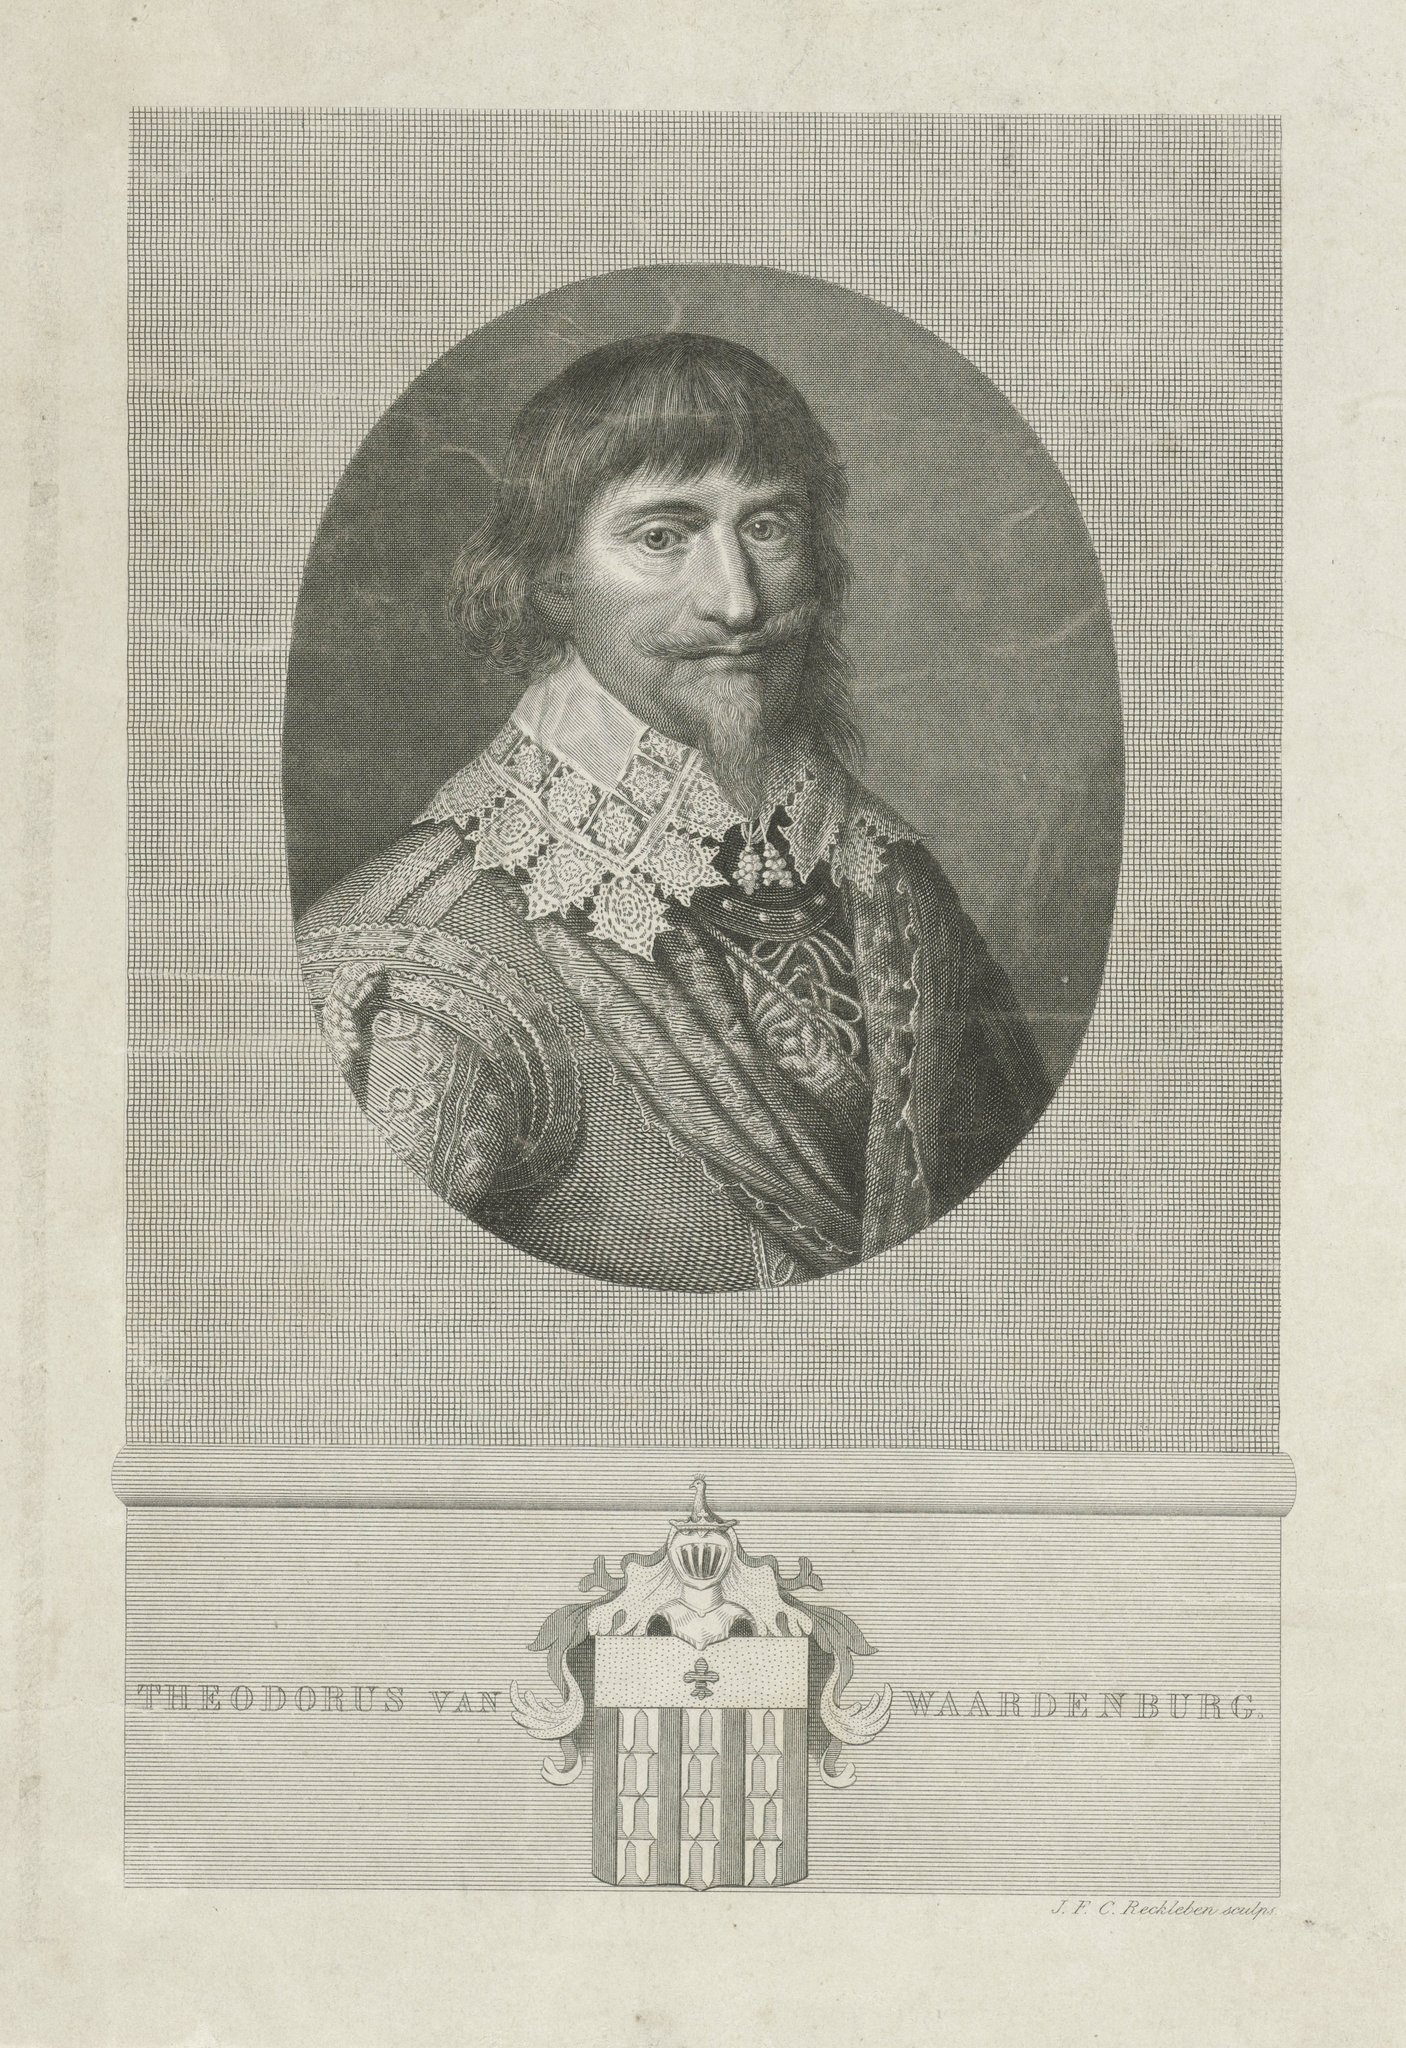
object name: print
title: Portret van Theodor van Weerdenburg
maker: jan frederik christiaan reckleben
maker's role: print maker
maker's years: 1819-1879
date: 1863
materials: paper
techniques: engraving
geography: amsterdam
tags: theodor van weerdenburg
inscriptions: collector's mark: Lugt 2228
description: Illustratie in: Arend, Johannes Pieter. Algemeene geschiedenis des vaderlands van de vroegste tijden tot op heden. 5 delen, Amsterdam: Schleijer, J.F. 1840-1884, dl. 3.4, p. 547.